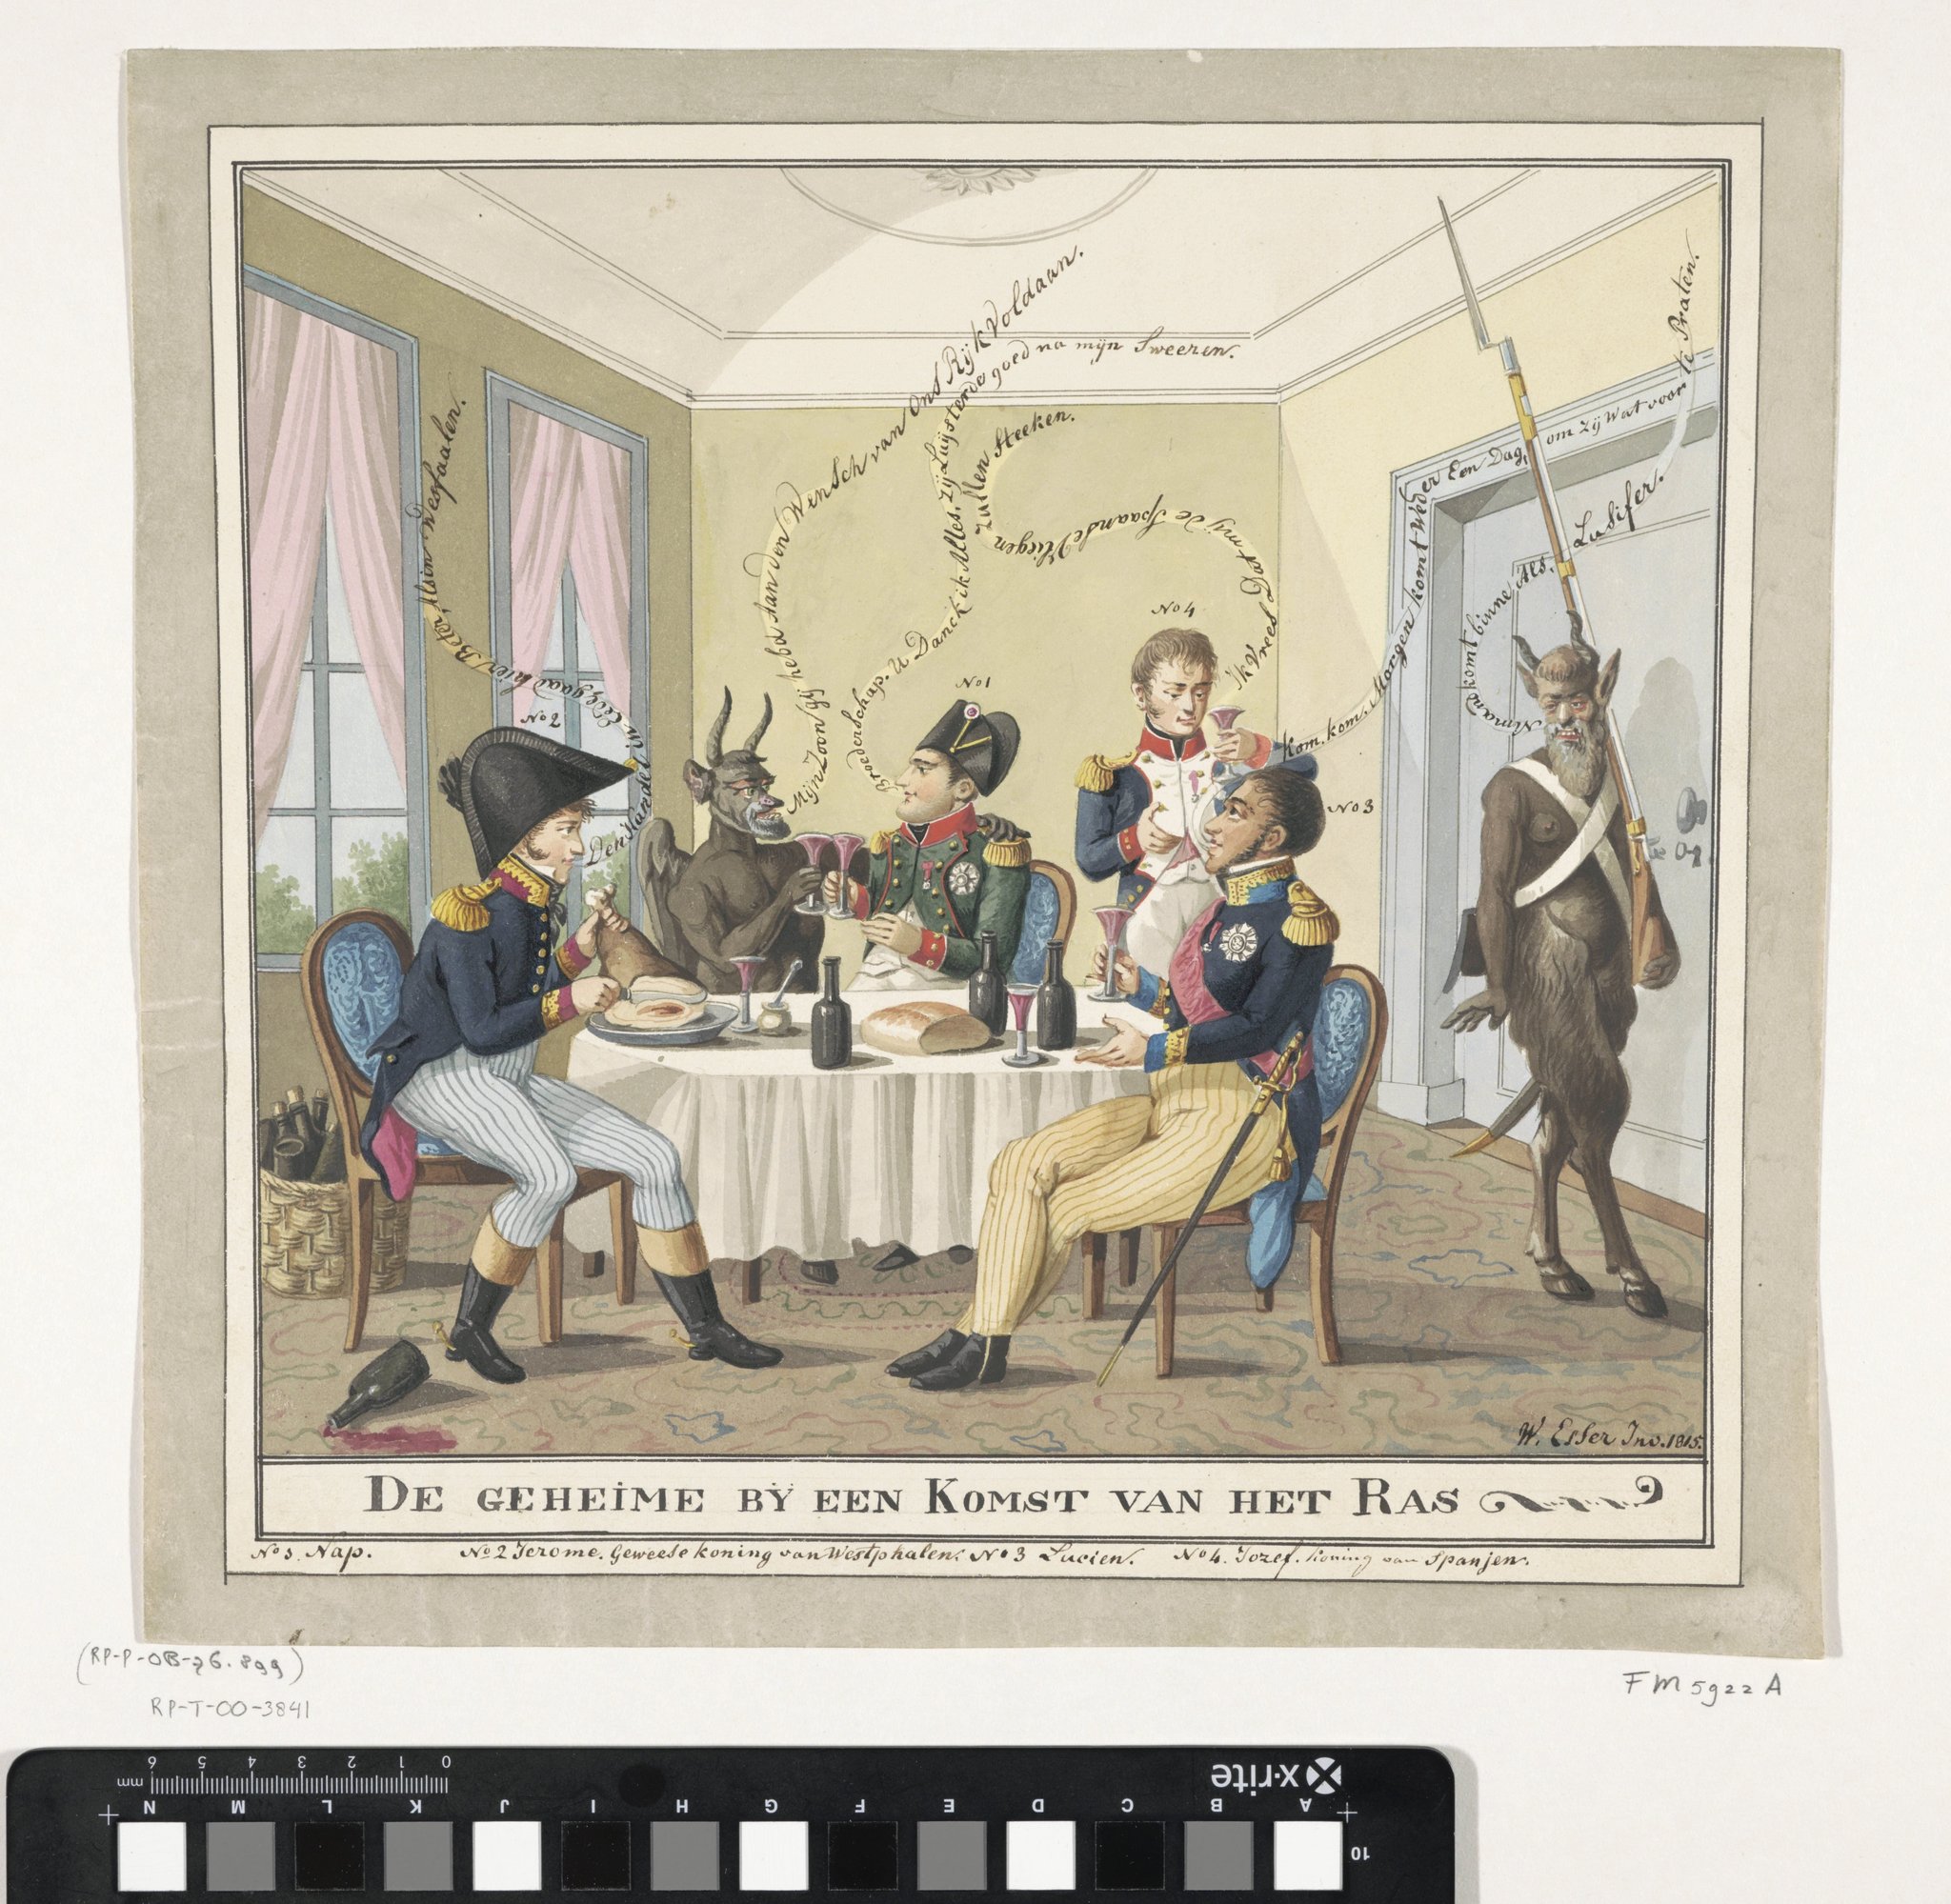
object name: cartoon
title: Geheime bijeenkomst van Napoleon en zijn broers, 1815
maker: wijnand esser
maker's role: draughtsman, print maker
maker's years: 1779-1860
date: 1815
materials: paper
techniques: brush, pen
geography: netherlands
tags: paris, napoleon i (emperor of the french), banquet of elegant company (+ toast at meal, banquet), devil(s) and demons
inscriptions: collector's mark: Lugt 2228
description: Spotprent op Napoleon en zijn broers, 1815. Keizer Napoleon gebruikt een maaltijd aan een tafel samen met zijn broers Jerome, Jozef en Lucien Bonaparte. Napoleon stoot het glas aan met de duivel. Bij de deur staat een andere duivel op wacht. Bij alle zes figuren banderollen met tekst.